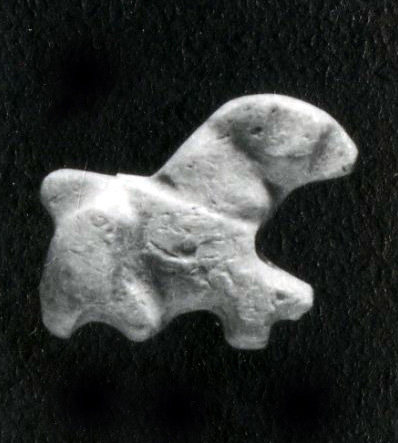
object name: amulet, dog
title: Dog (?) amulet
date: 2110-2030 BCE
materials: ivory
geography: egypt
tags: dogs